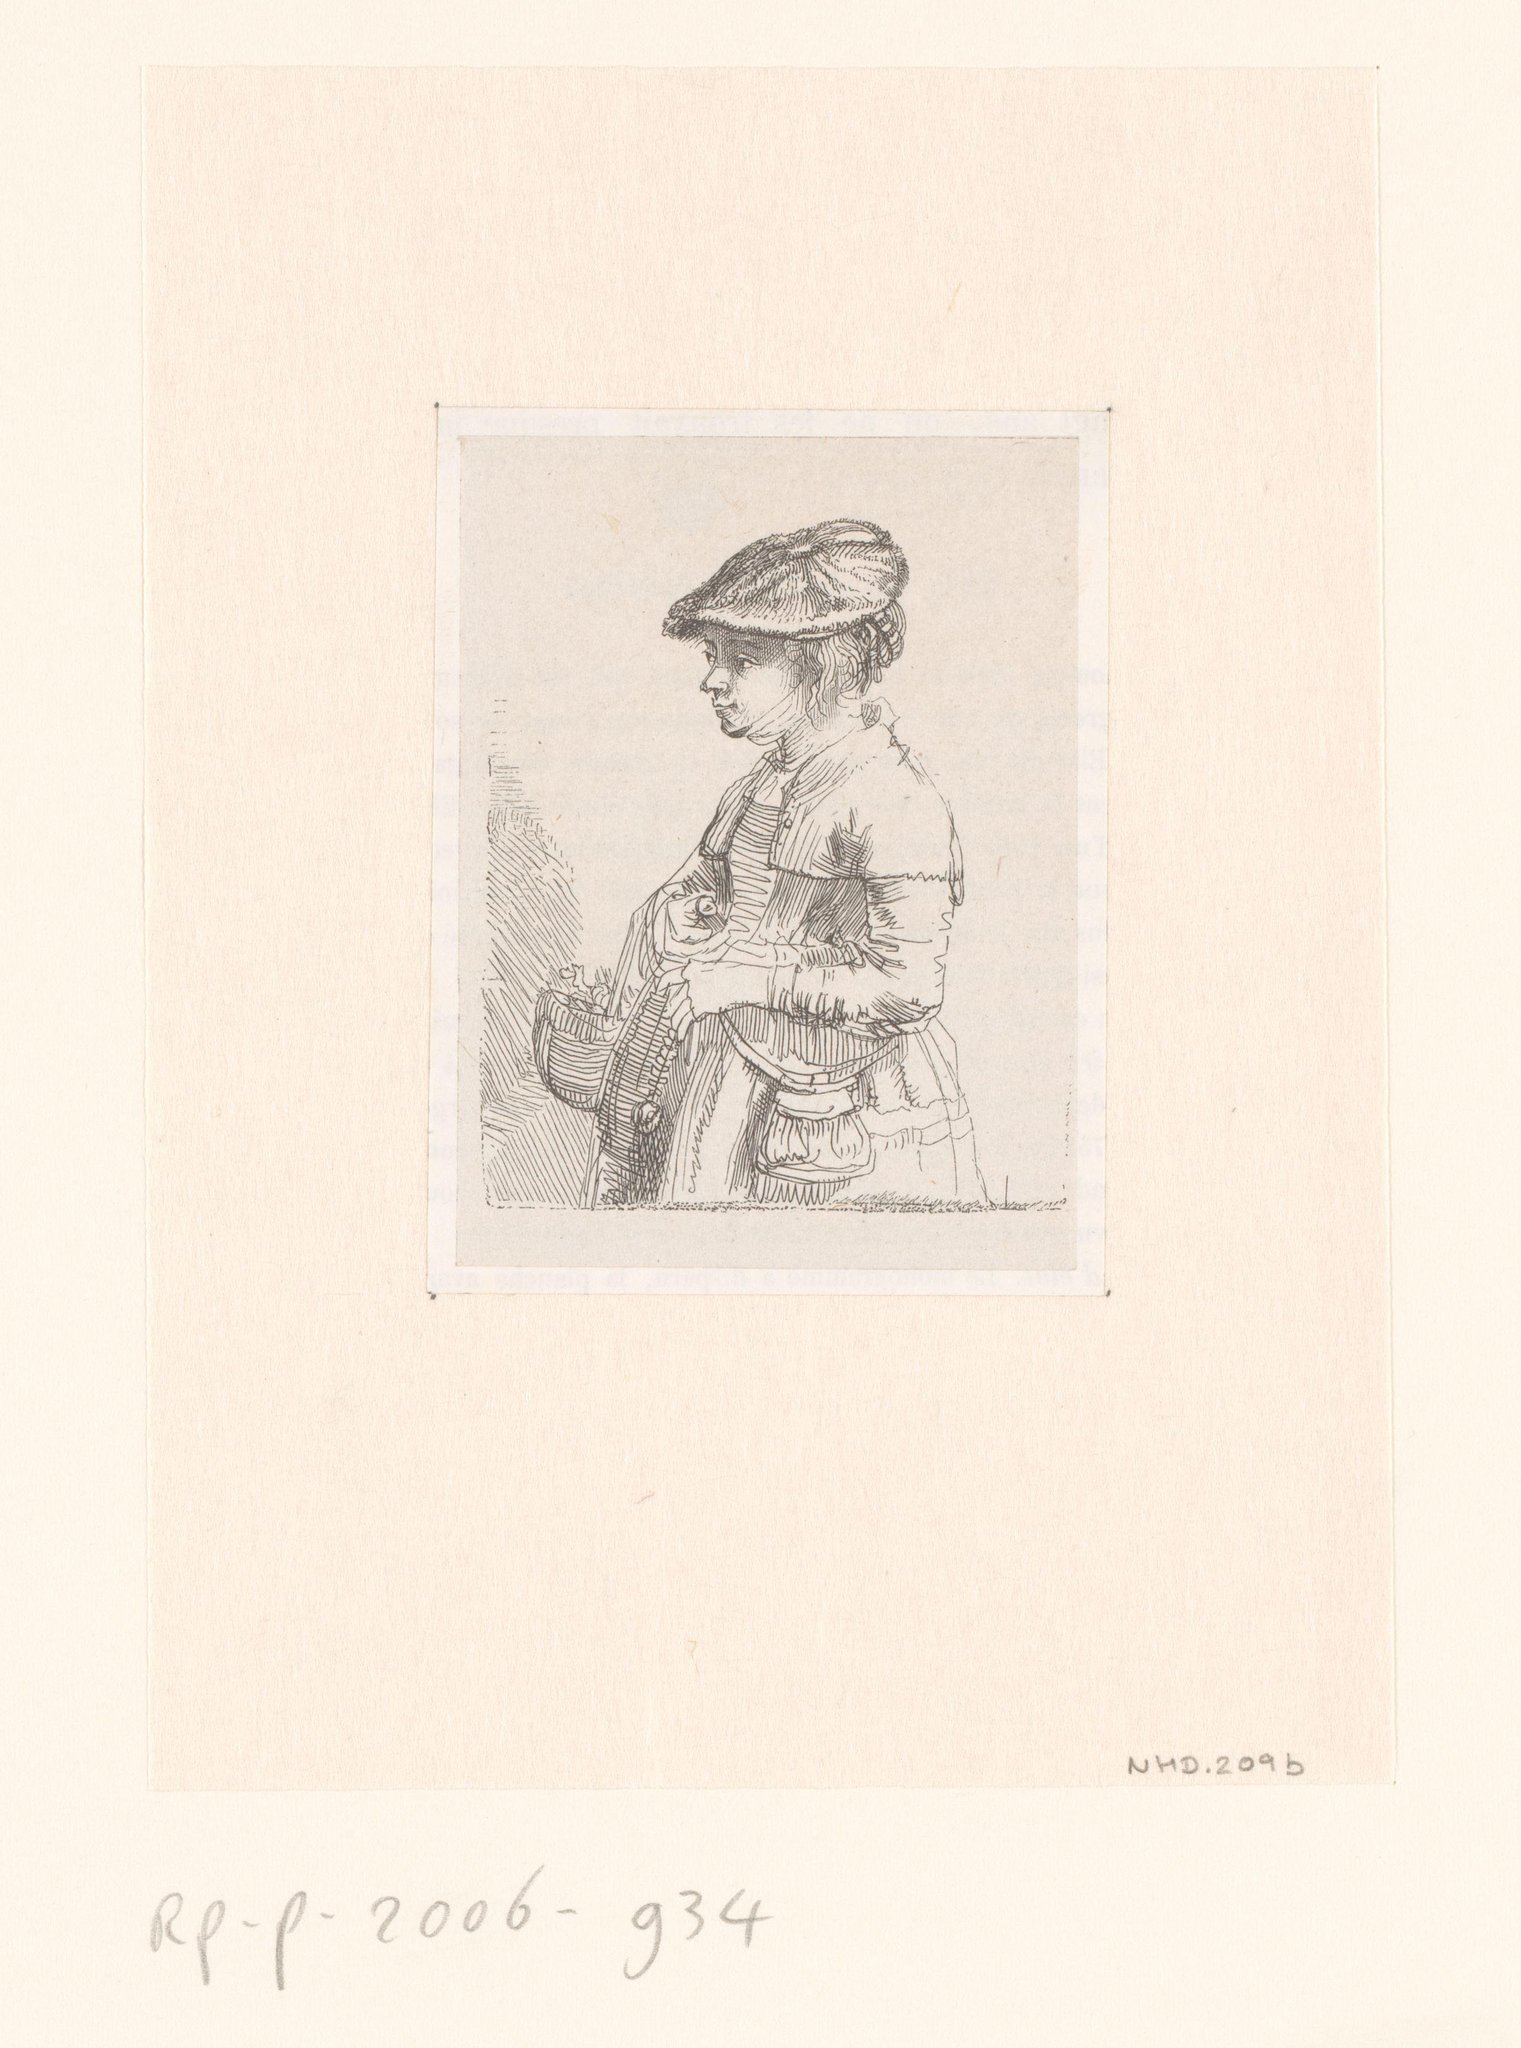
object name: print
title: Girl with a basket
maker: léopold flameng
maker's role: print maker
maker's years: 1831-1911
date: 1859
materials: paper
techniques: etching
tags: adolescent, young woman, maiden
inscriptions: collector's mark: Lugt 2228, collector's mark: Lugt 2760